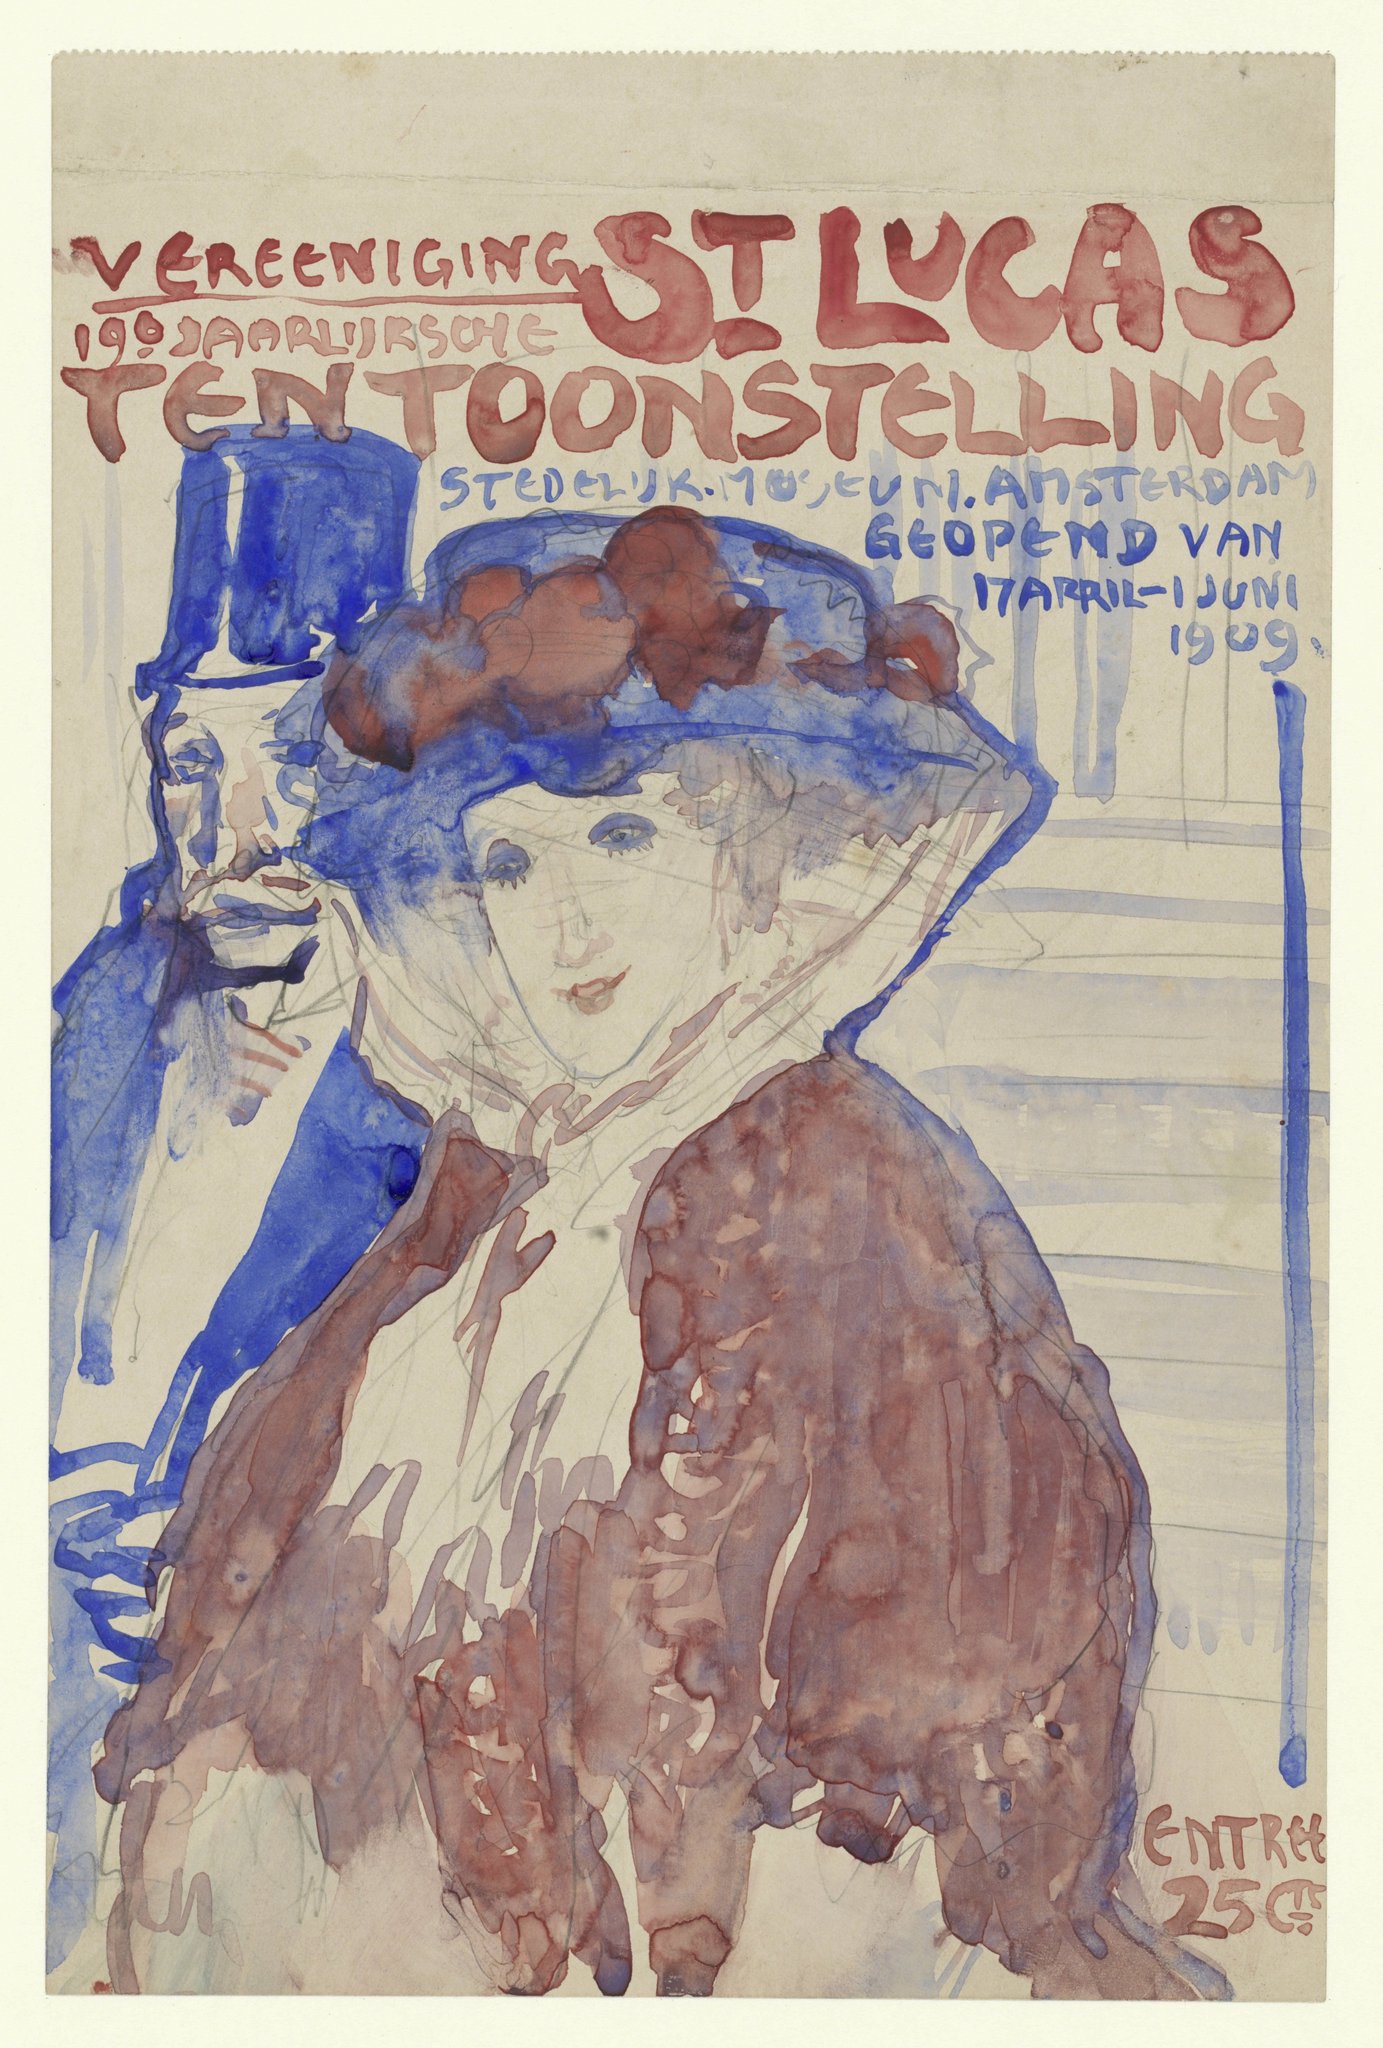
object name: watercolor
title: Ontwerp voor de afiche van de 19e jaarlijkse Tentoonstelling van Vereening St. Lukas in het Stedelijk Museum te Amsterdam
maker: leo gestel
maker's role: draughtsman, print maker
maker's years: 1881-1941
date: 1891-1941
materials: paper, pencil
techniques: brush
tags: names of organizations, companies, trade unions, etc., amsterdam